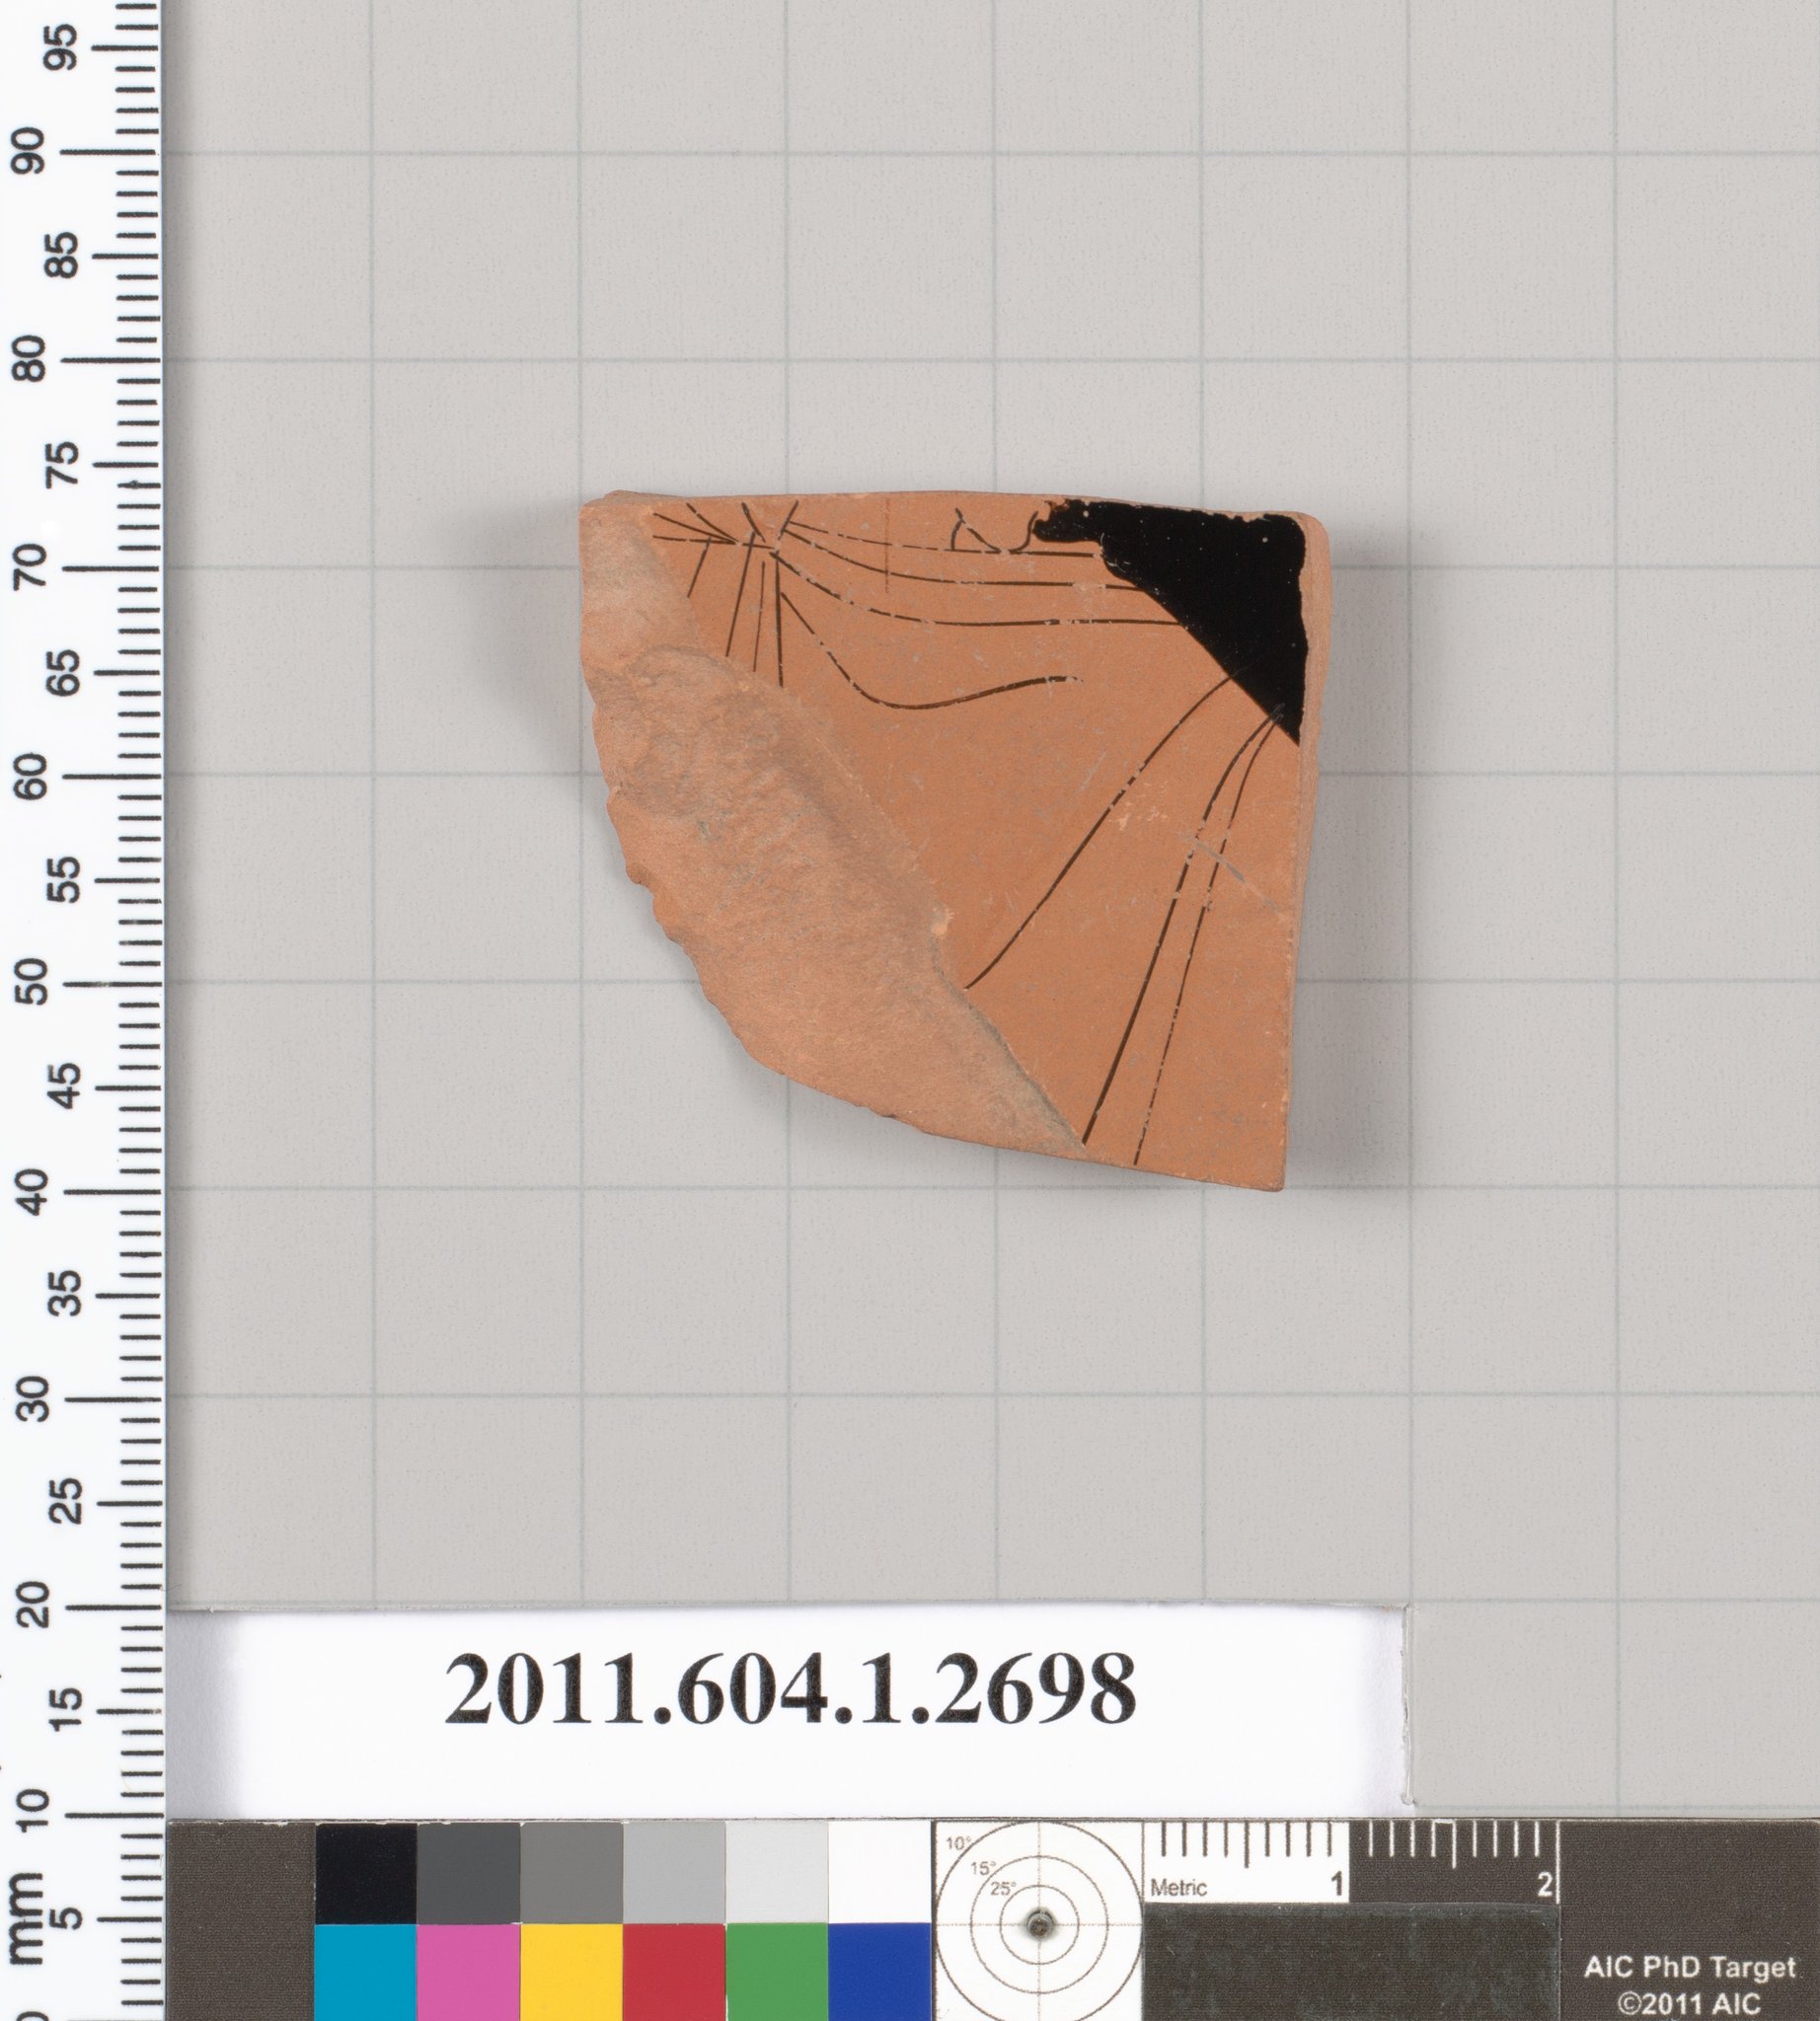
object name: kylix fragment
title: Terracotta fragment of a kylix (drinking cup)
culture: greek, attic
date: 490-470 BCE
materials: terracotta